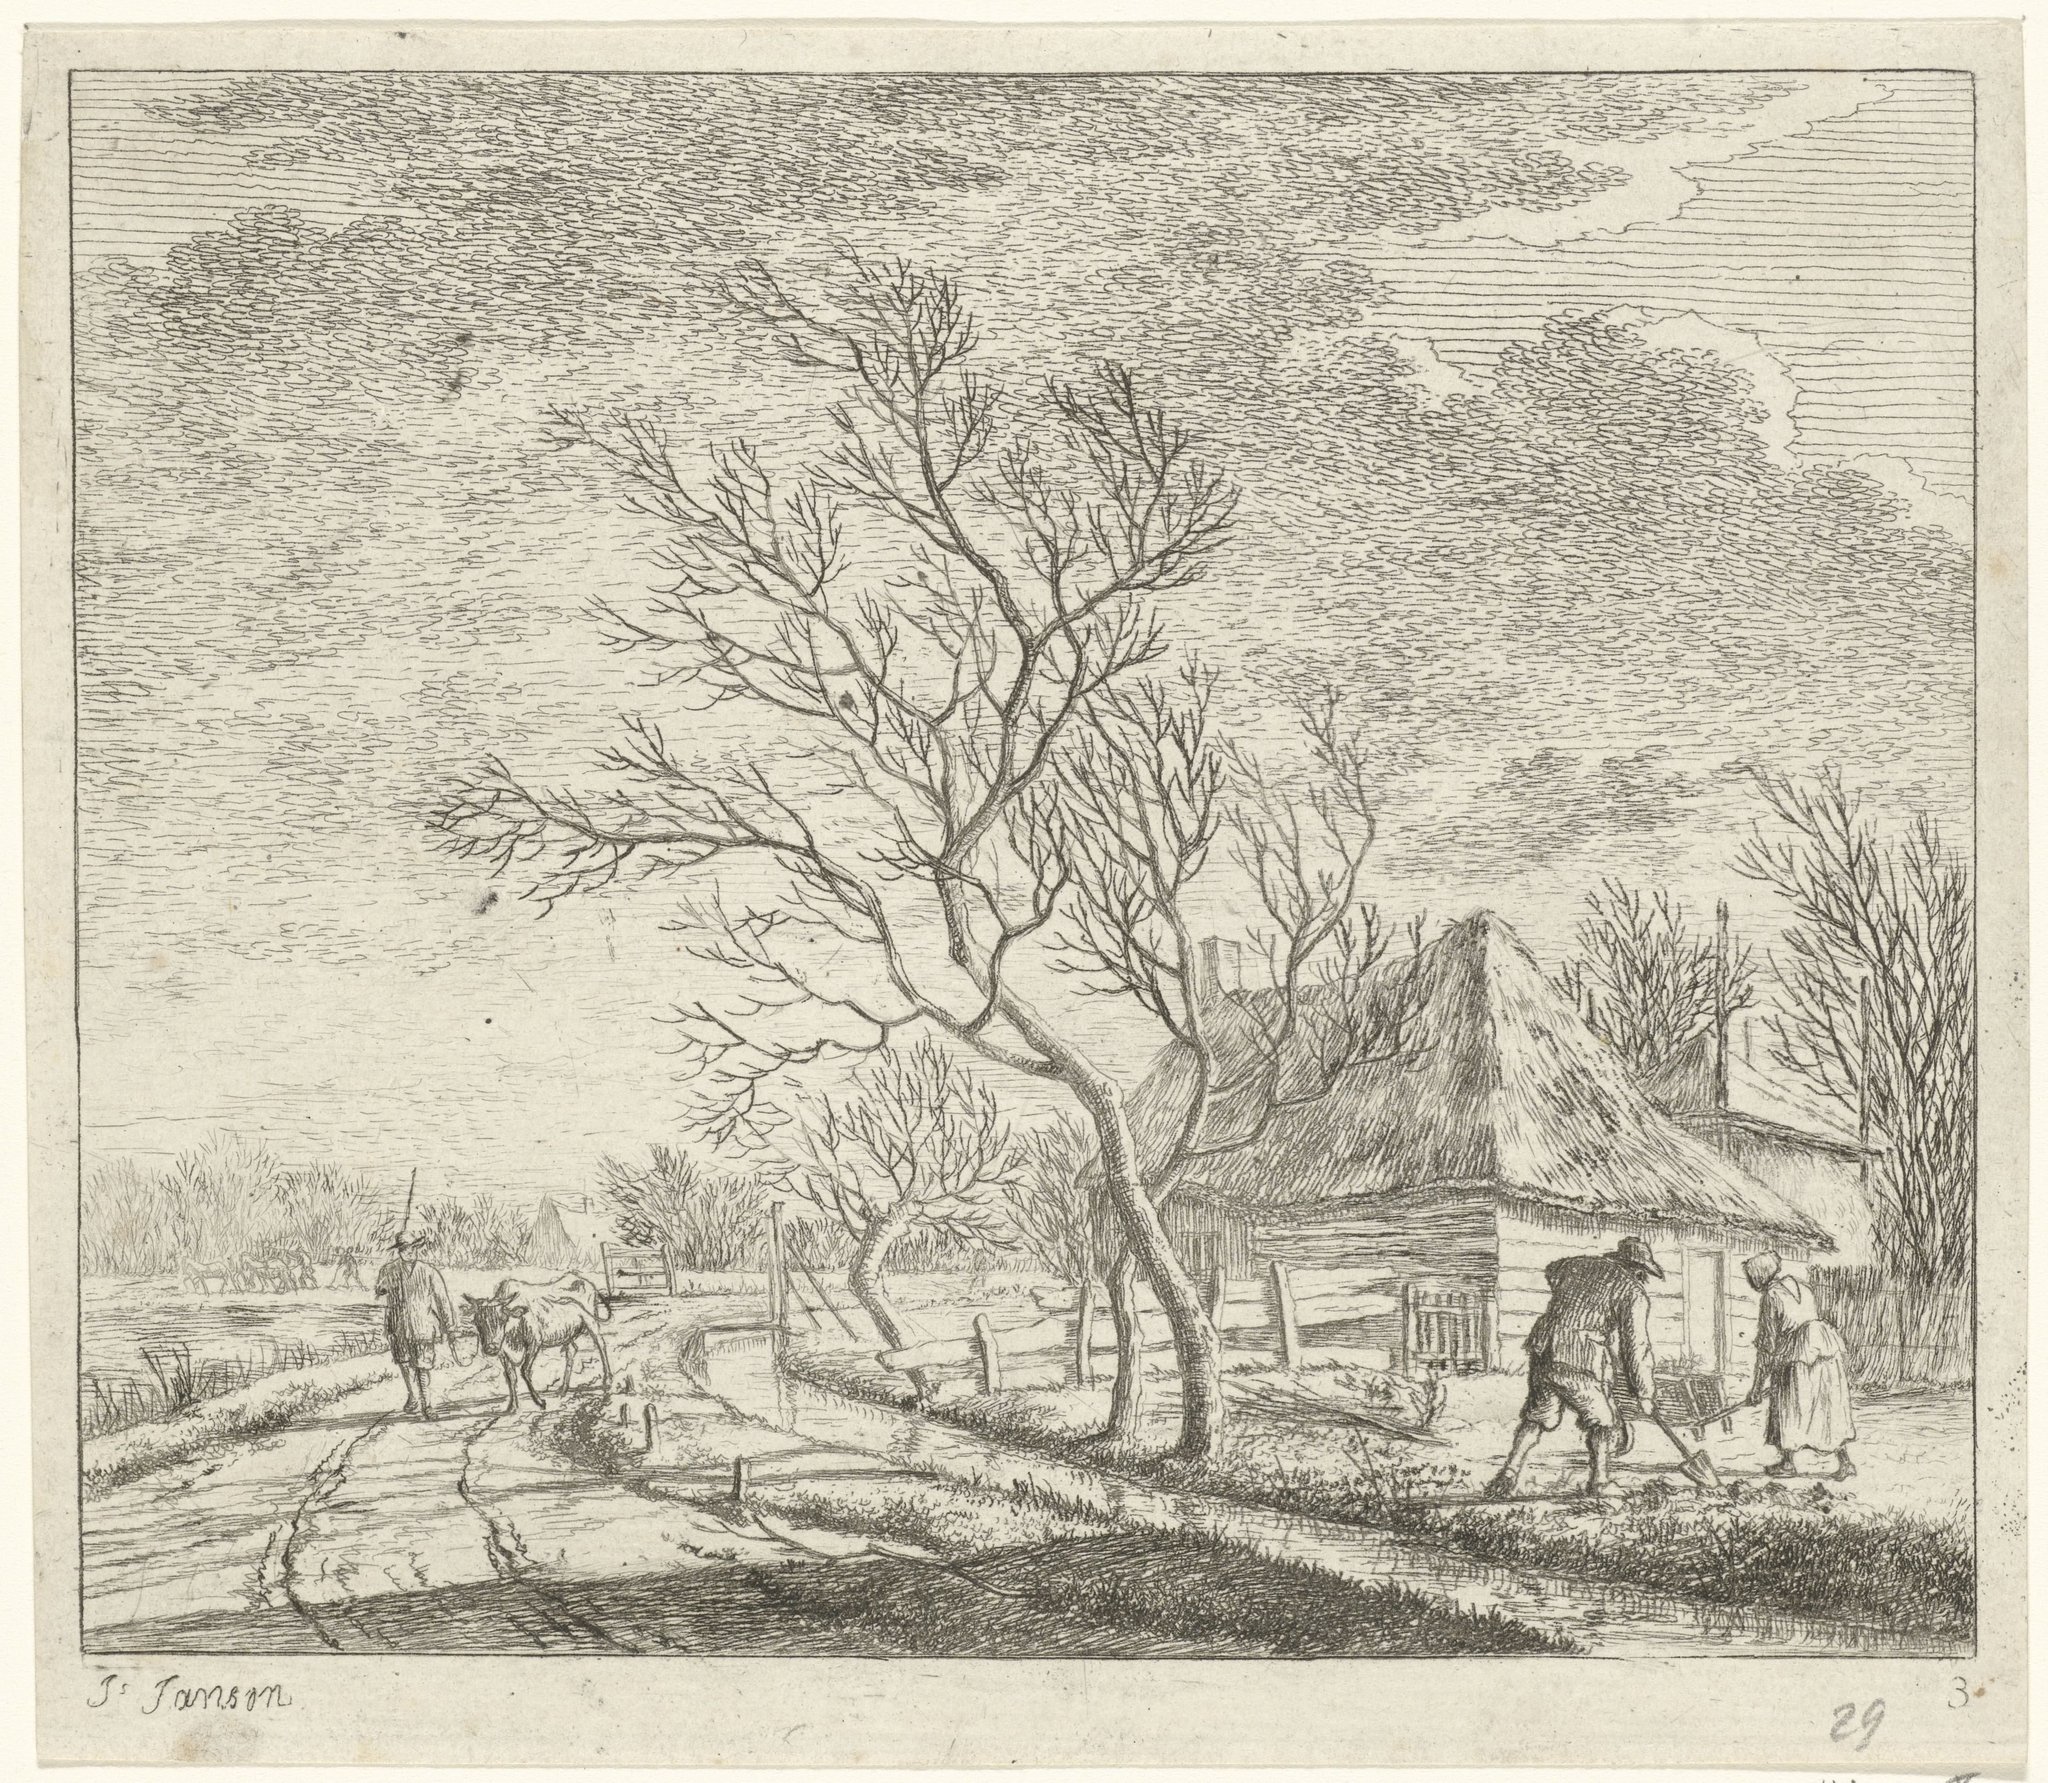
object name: print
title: De twaalf maanden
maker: johannes janson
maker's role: draughtsman, painter, print maker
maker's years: 1729-1784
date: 1783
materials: paper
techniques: etching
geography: leiden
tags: landscape symbolizing march, farmers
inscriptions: collector's mark: Lugt 2228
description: Landschap met boerderij, boer met schep en boerin met kruiwagen, aan het werk op hun land. Links een pad met een man met koe. Links op de achtergrond boeren en paarden op een akker. Rechtsonder: 3. Vierde prent uit een serie van dertien met maanden.